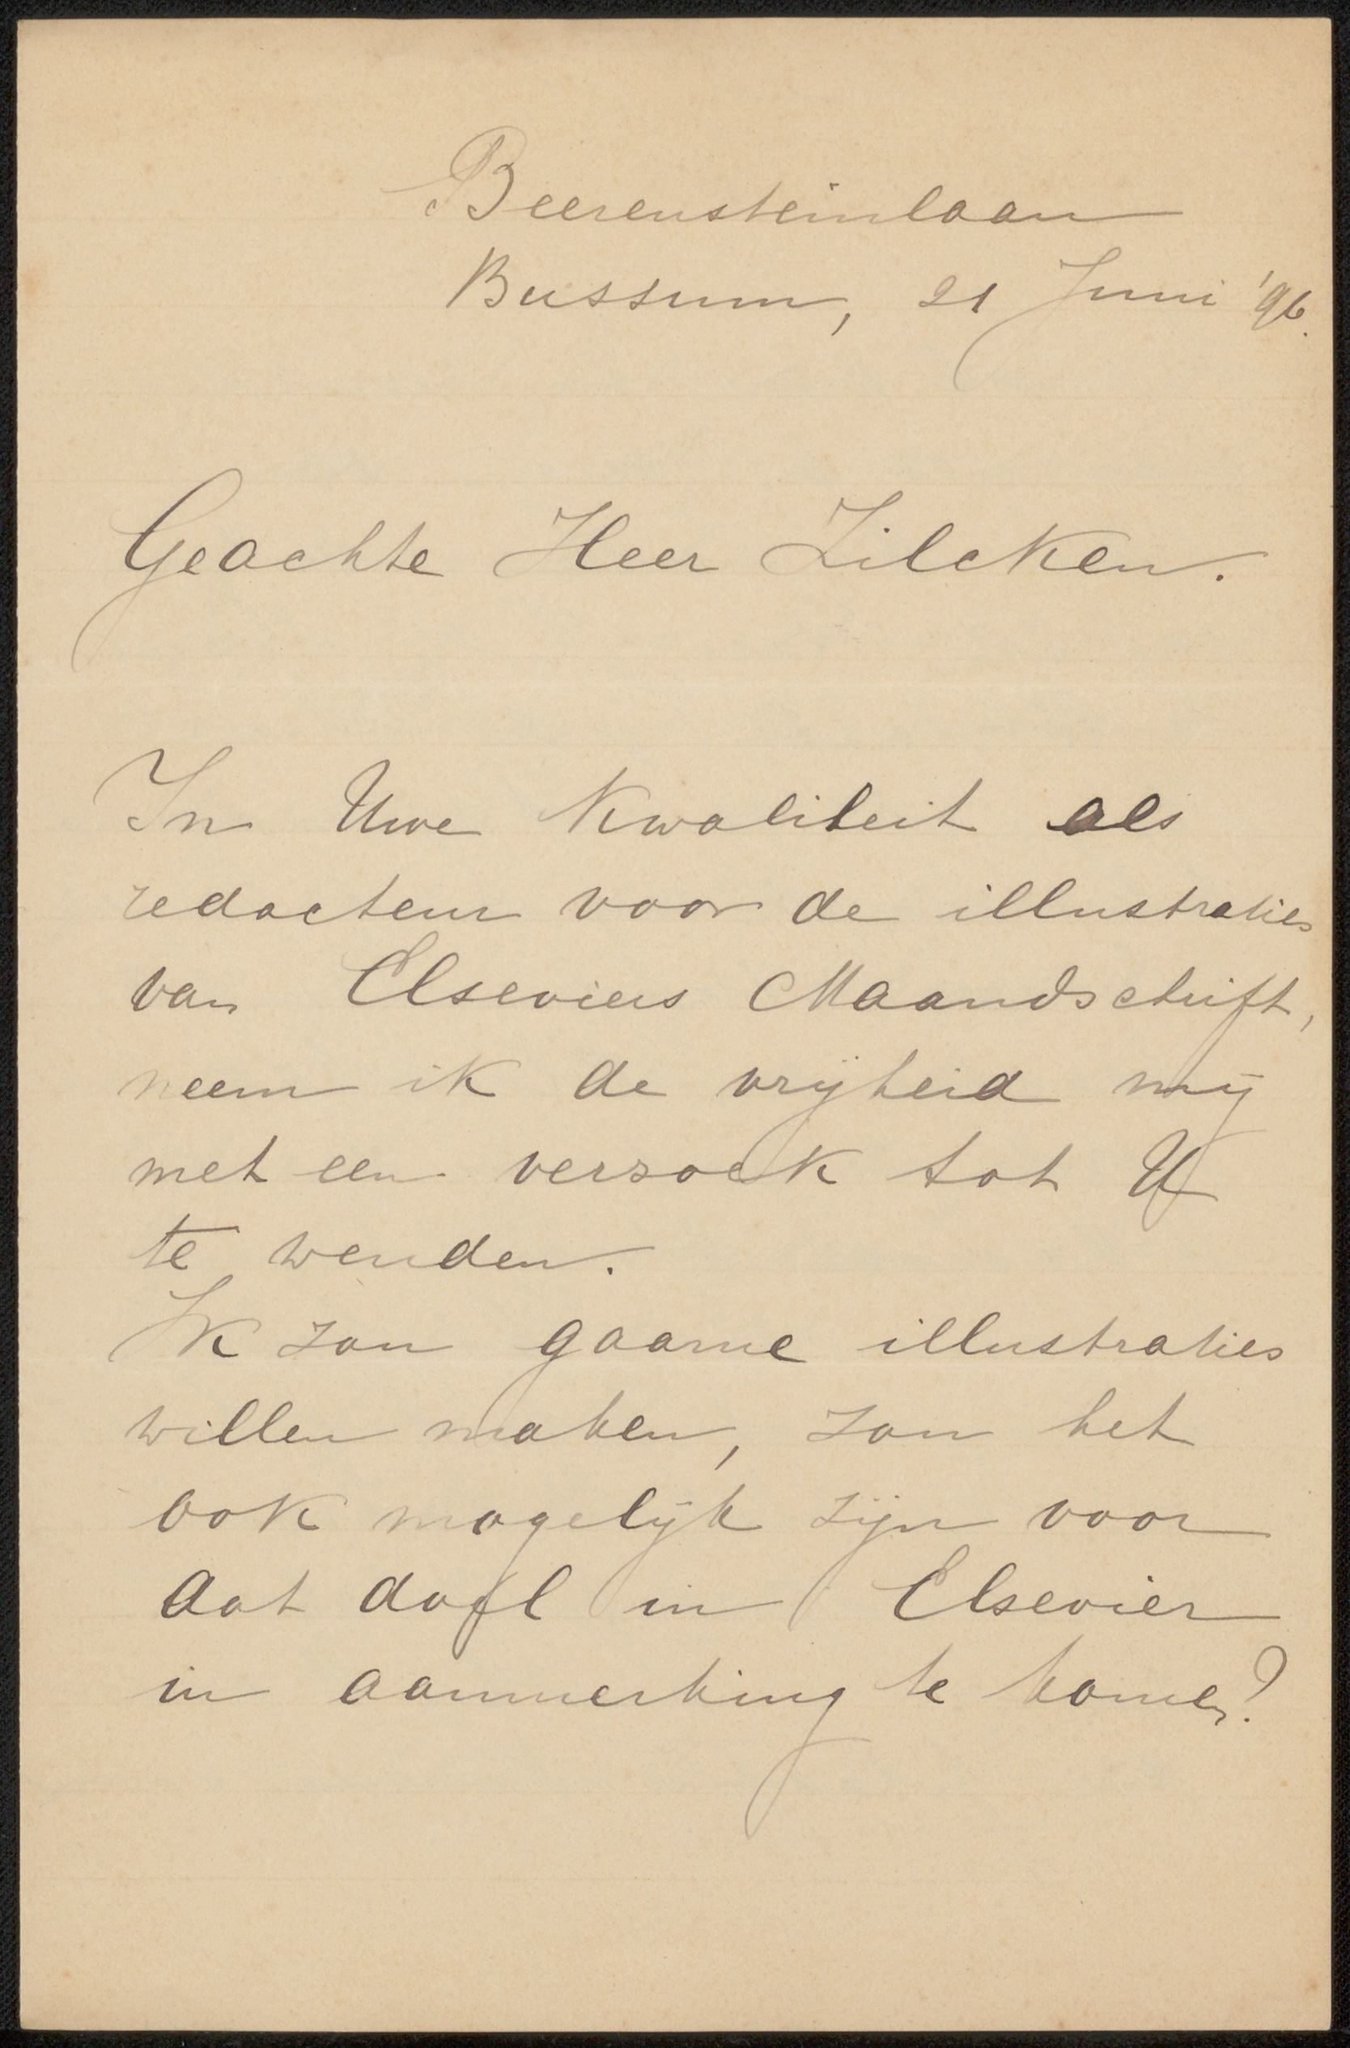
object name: letter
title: Brief aan Philip Zilcken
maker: henriëtte de vries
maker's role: draughtsman, print maker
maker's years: 1867-1942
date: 1896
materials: ink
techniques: pen, writing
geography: bussum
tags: jan hoynck van papendrecht, utrecht, publisher, painter, philip zilcken, illustration ~ printed matter, book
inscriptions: collector's mark: ‘RPK’